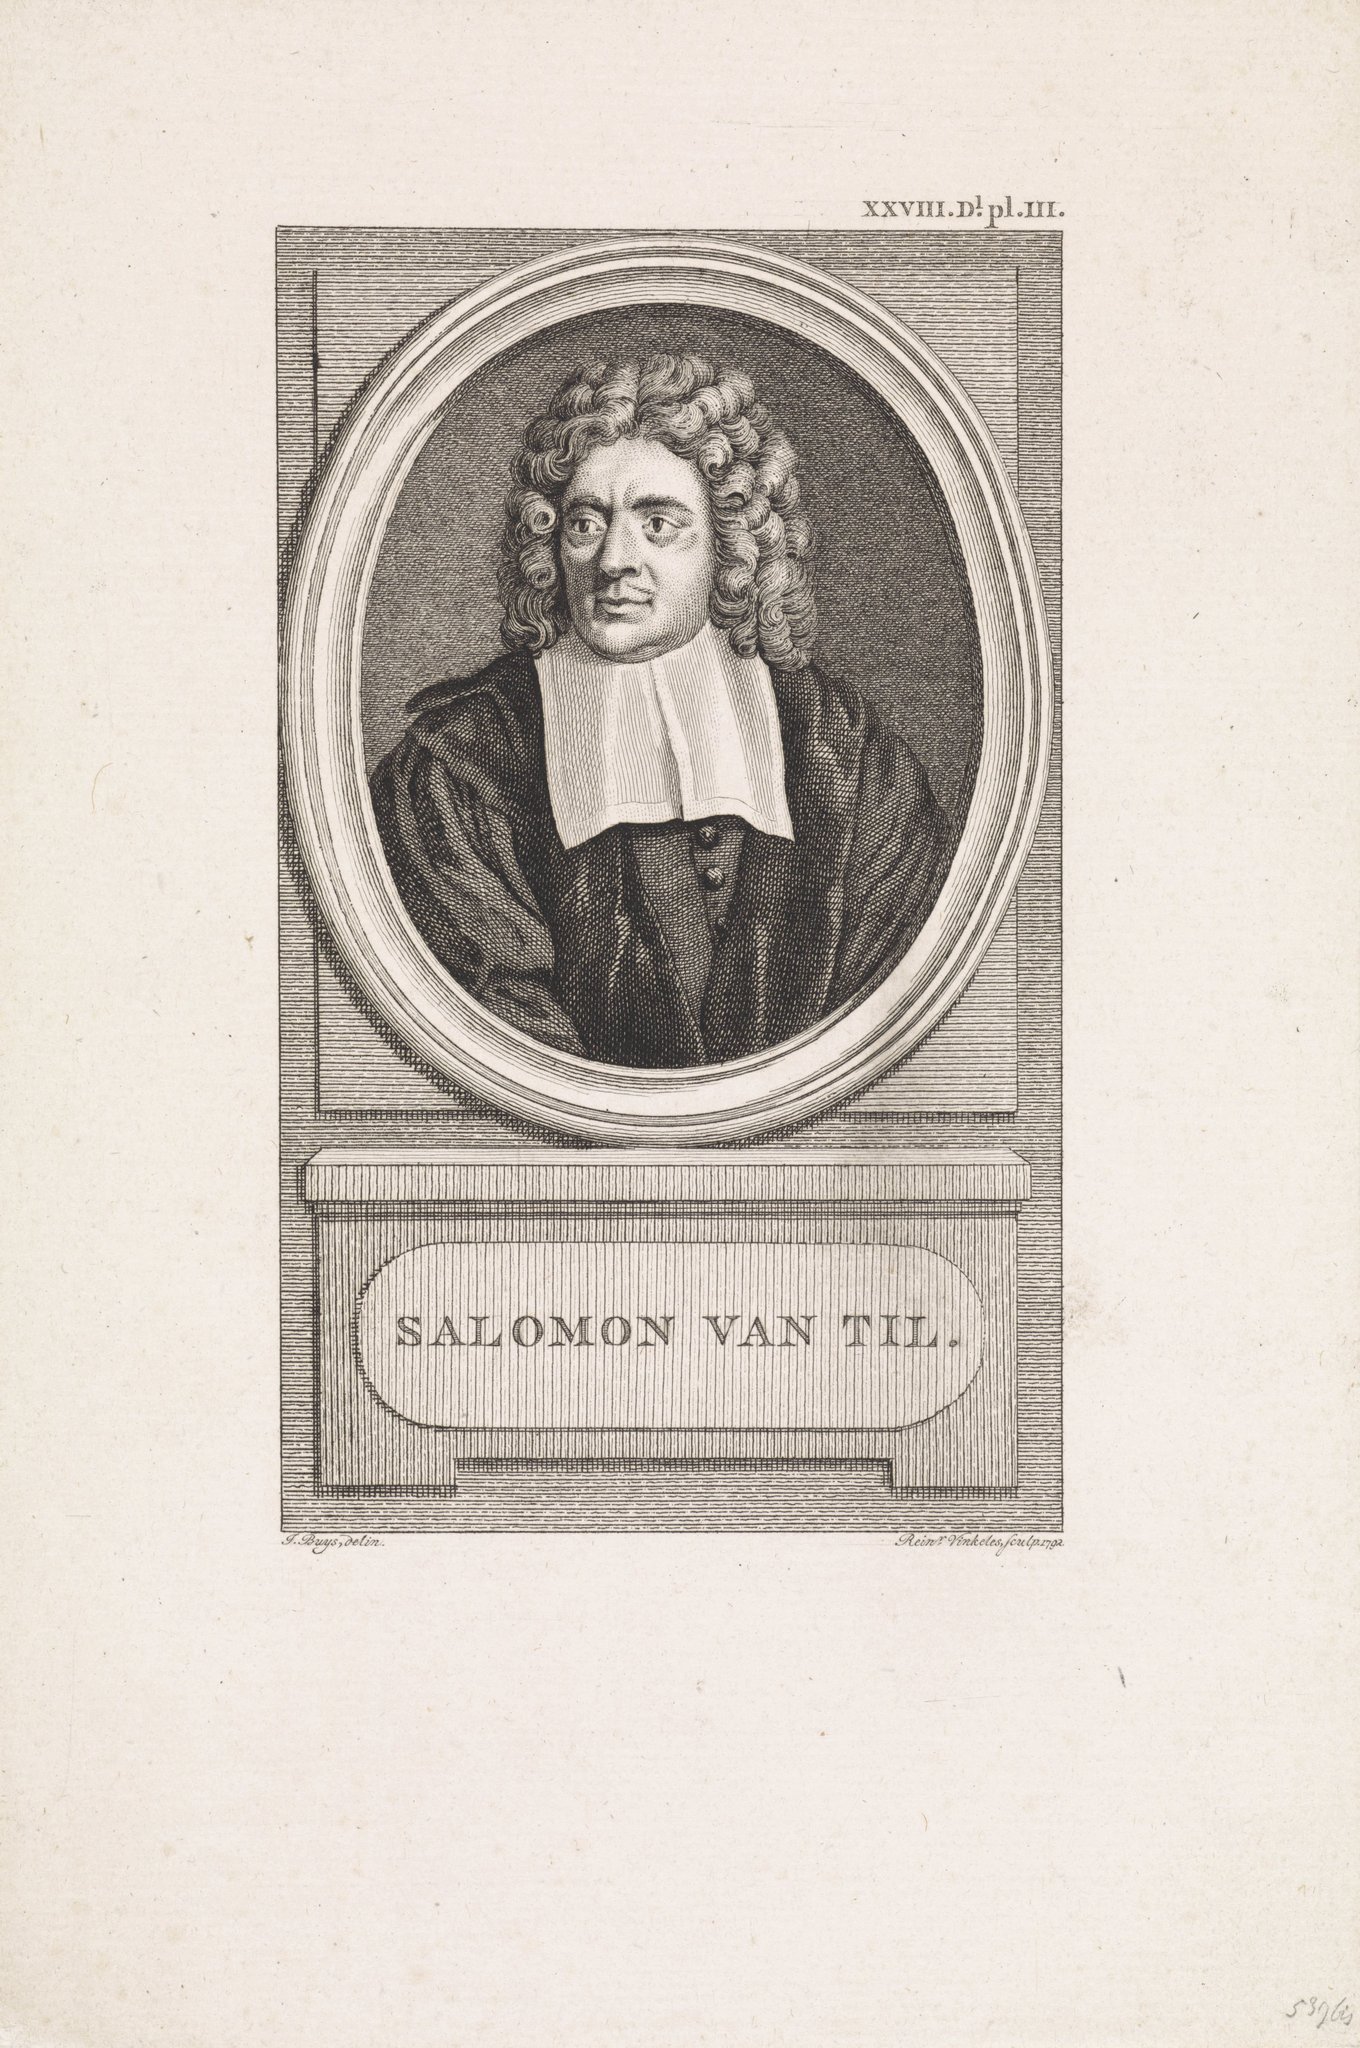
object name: print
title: Portret van Salomon van Til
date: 1792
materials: paper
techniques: engraving, etching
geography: amsterdam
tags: leiden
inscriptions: collector's mark: Lugt 2228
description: Prent gebruikt als boekillustratie in: Kok, Jacobus. Vaderlandsch woordenboek : met kaarten, plaaten en pourtraitten. Amsterdam: Johannes Allart, 1785-1796. Deeel XXVIII.